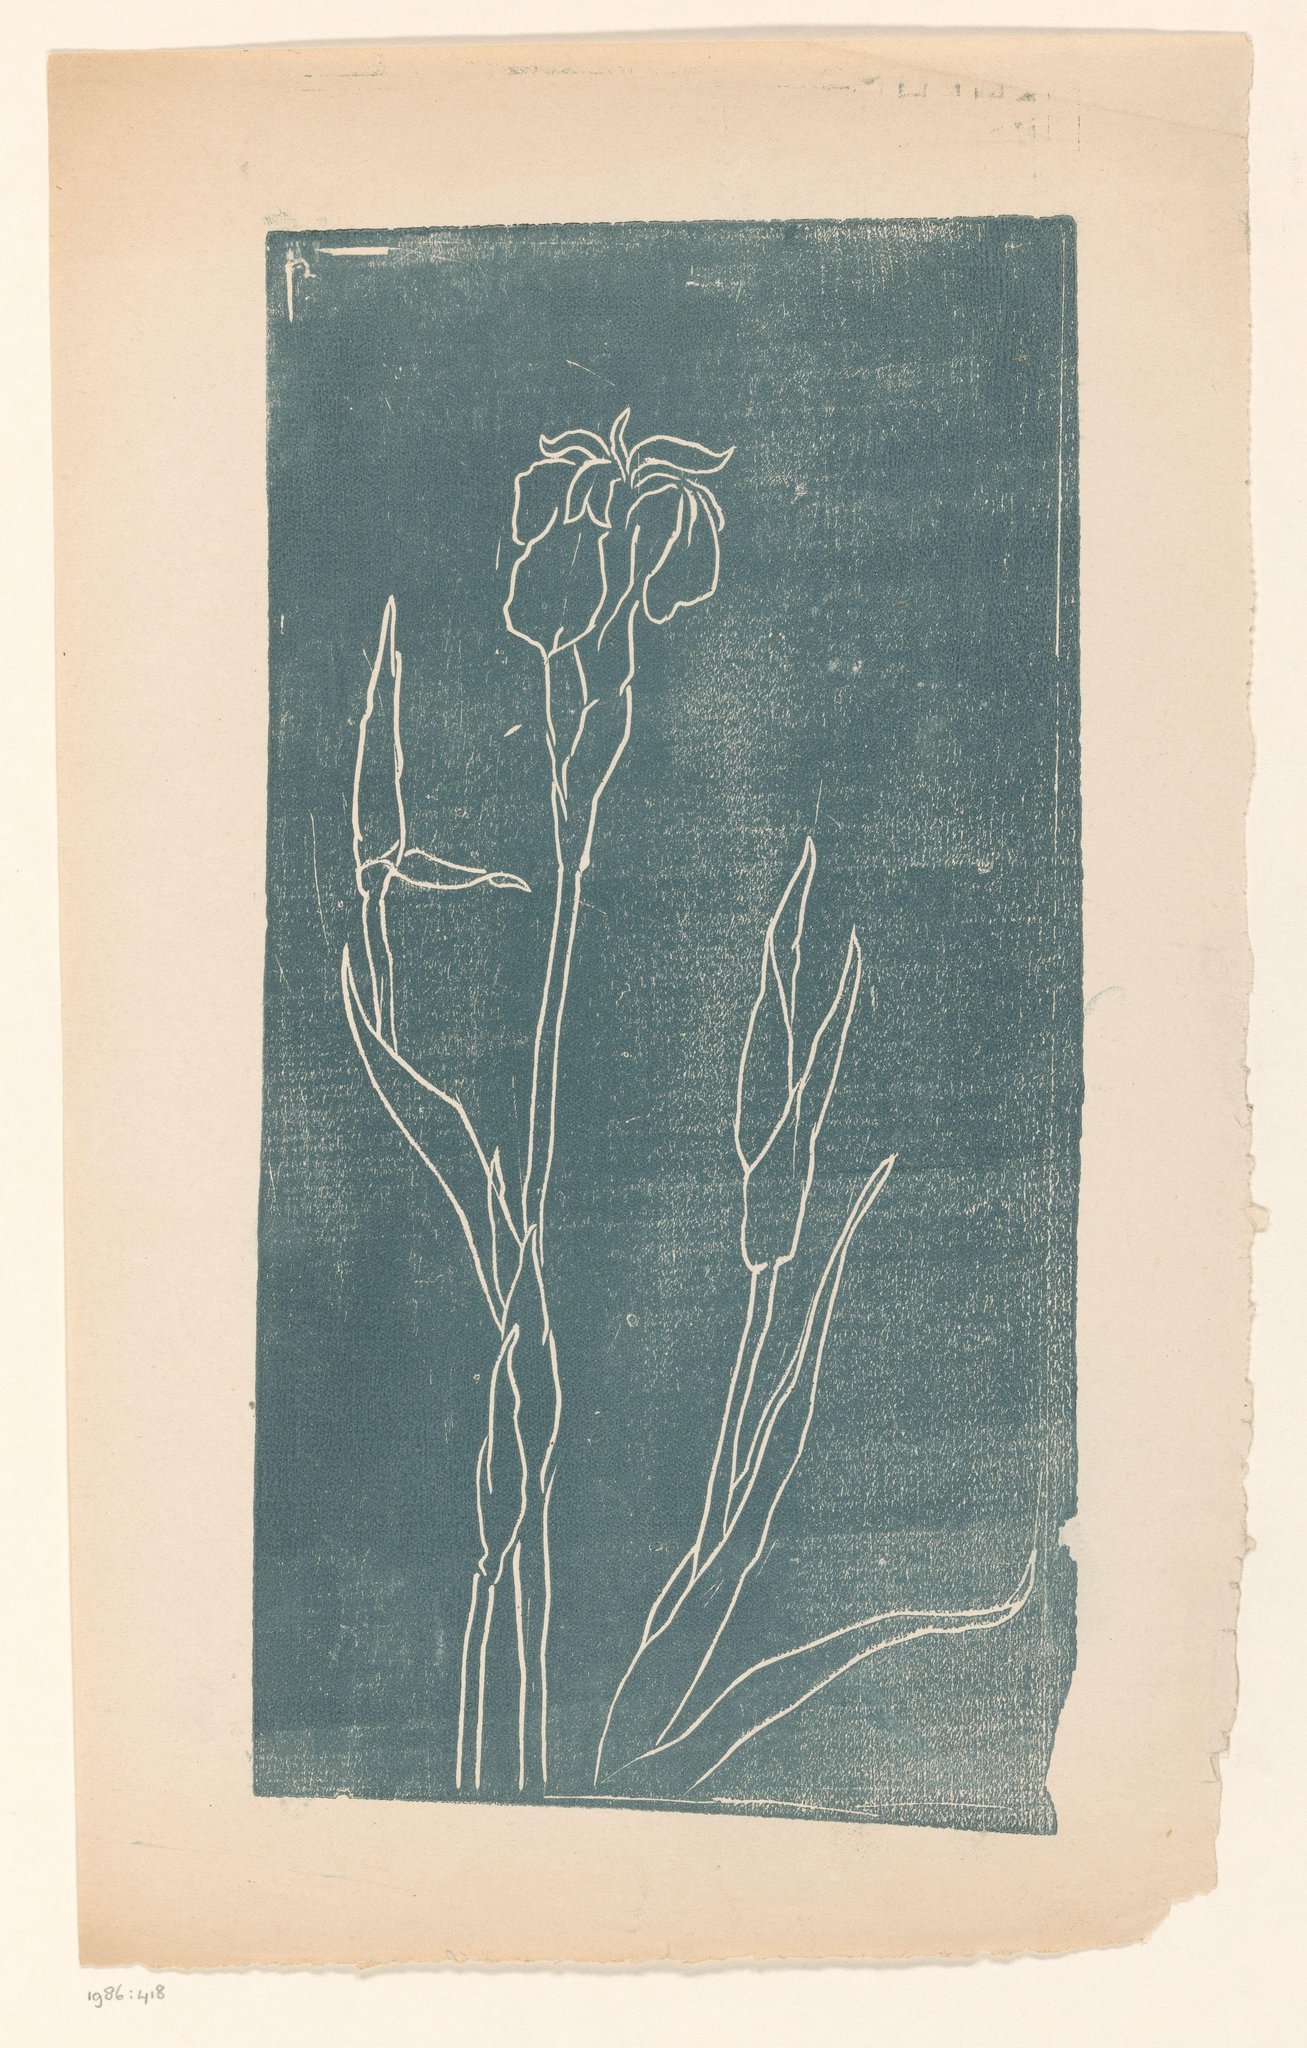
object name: print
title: Iris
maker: reinier willem petrus de vries (1874-1953)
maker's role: draughtsman, print maker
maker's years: 1874-1953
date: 1884-1952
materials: paper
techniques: linocut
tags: flowers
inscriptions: collector's mark: Lugt 2228